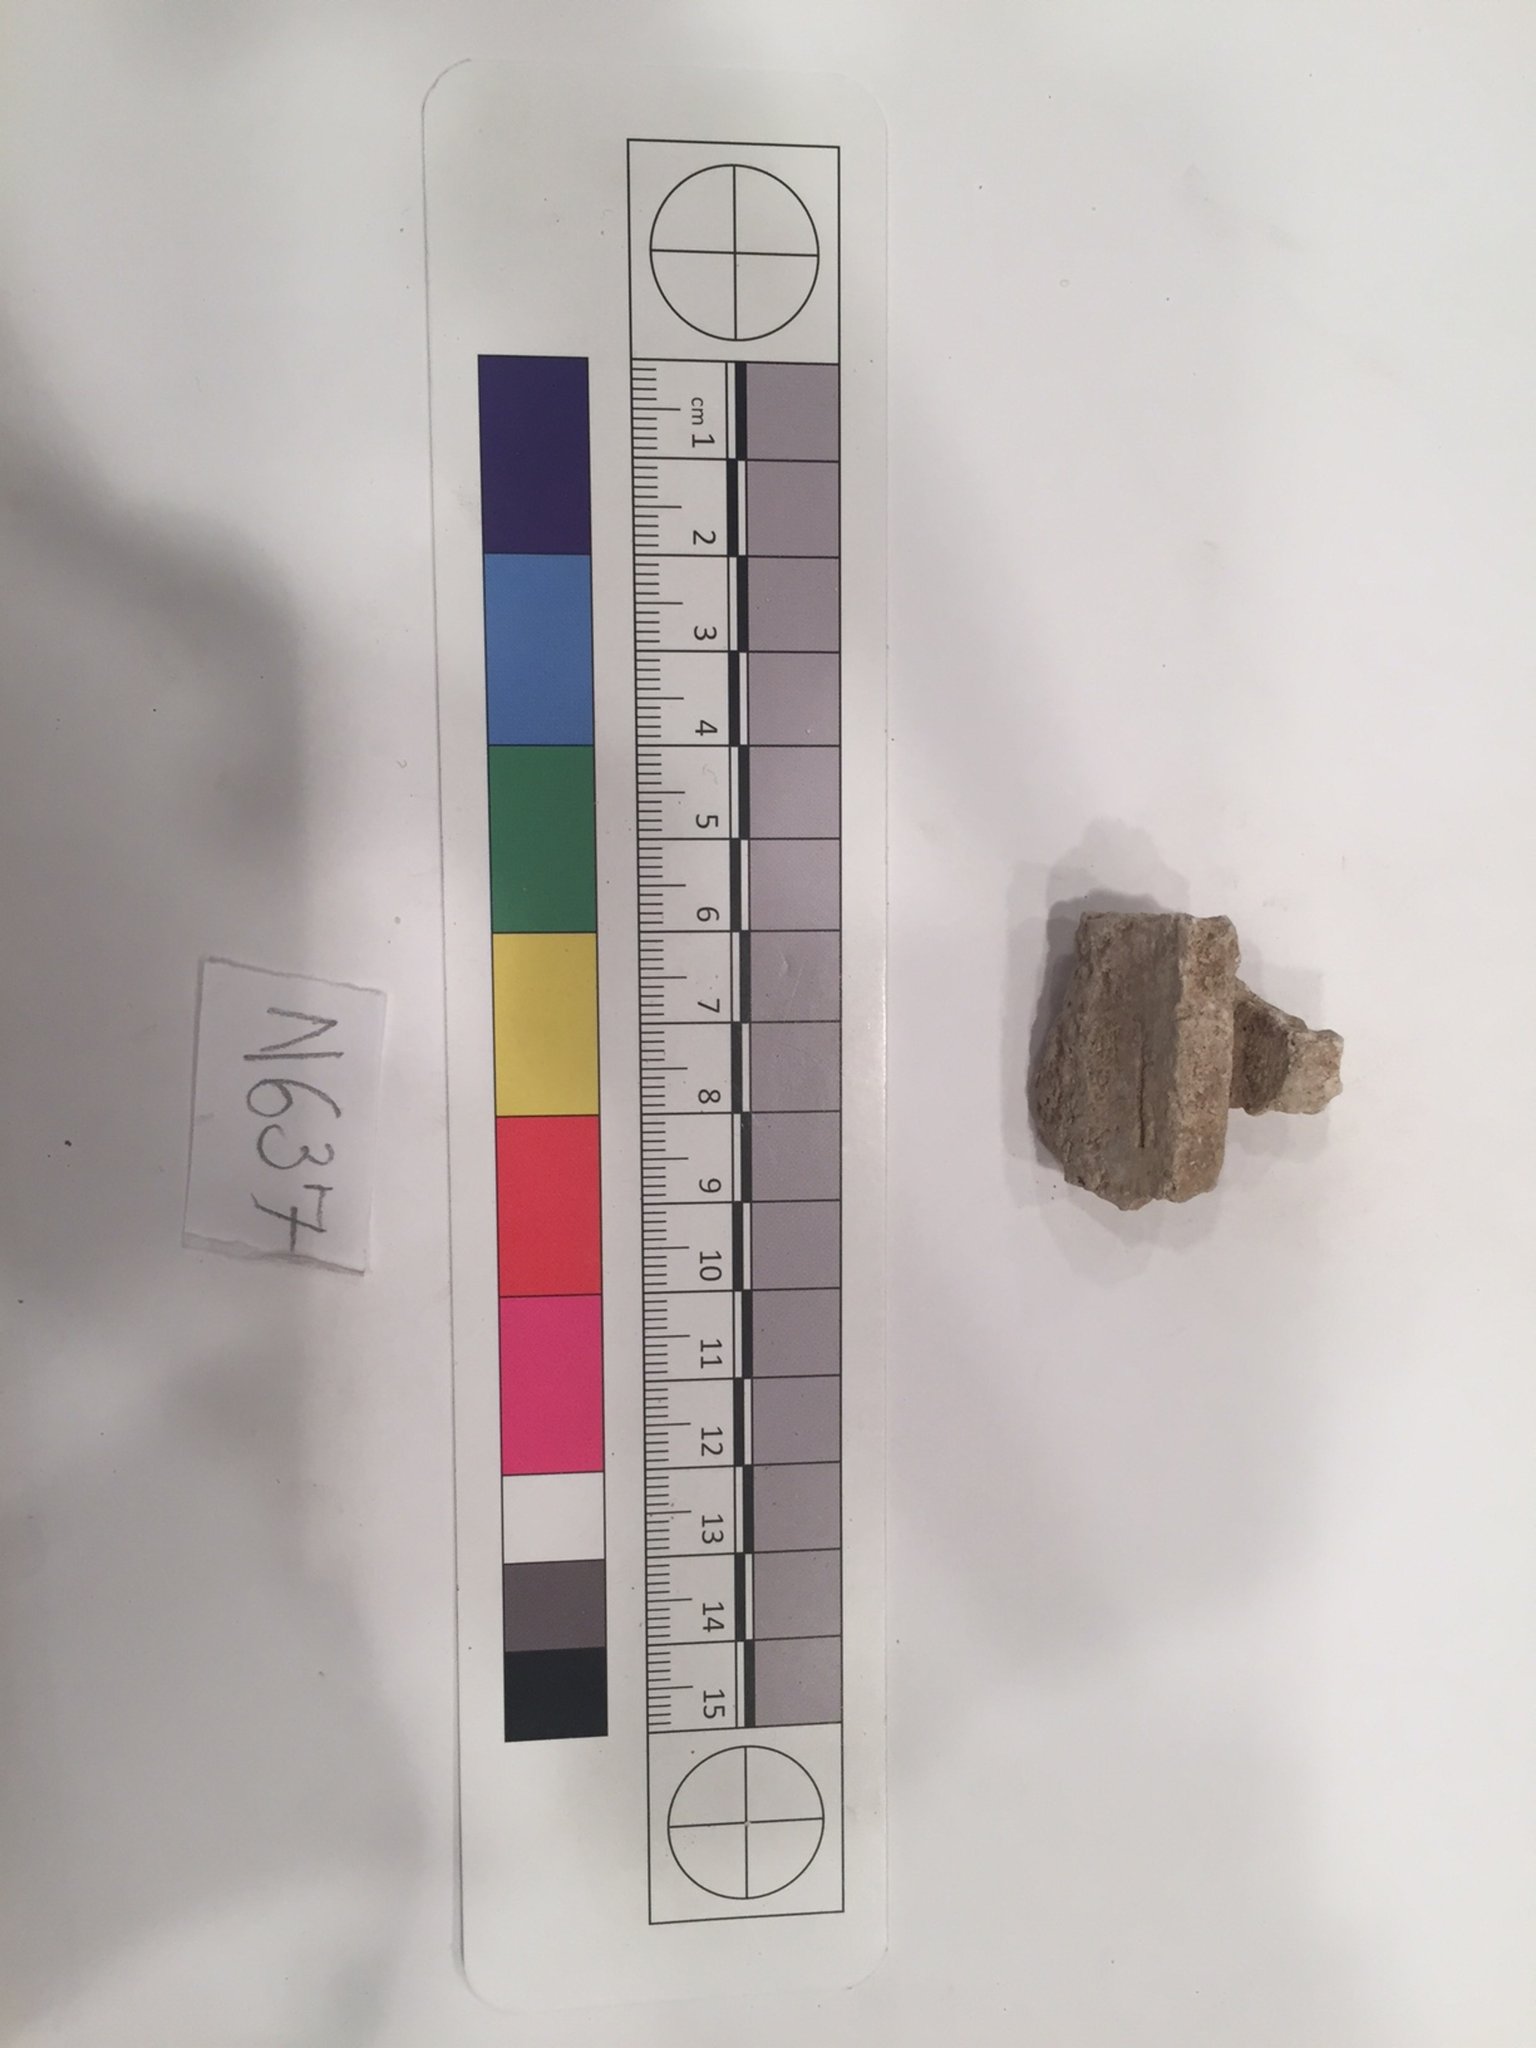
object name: fragment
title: Stucco Fragment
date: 701-1200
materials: plaster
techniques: carving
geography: iran